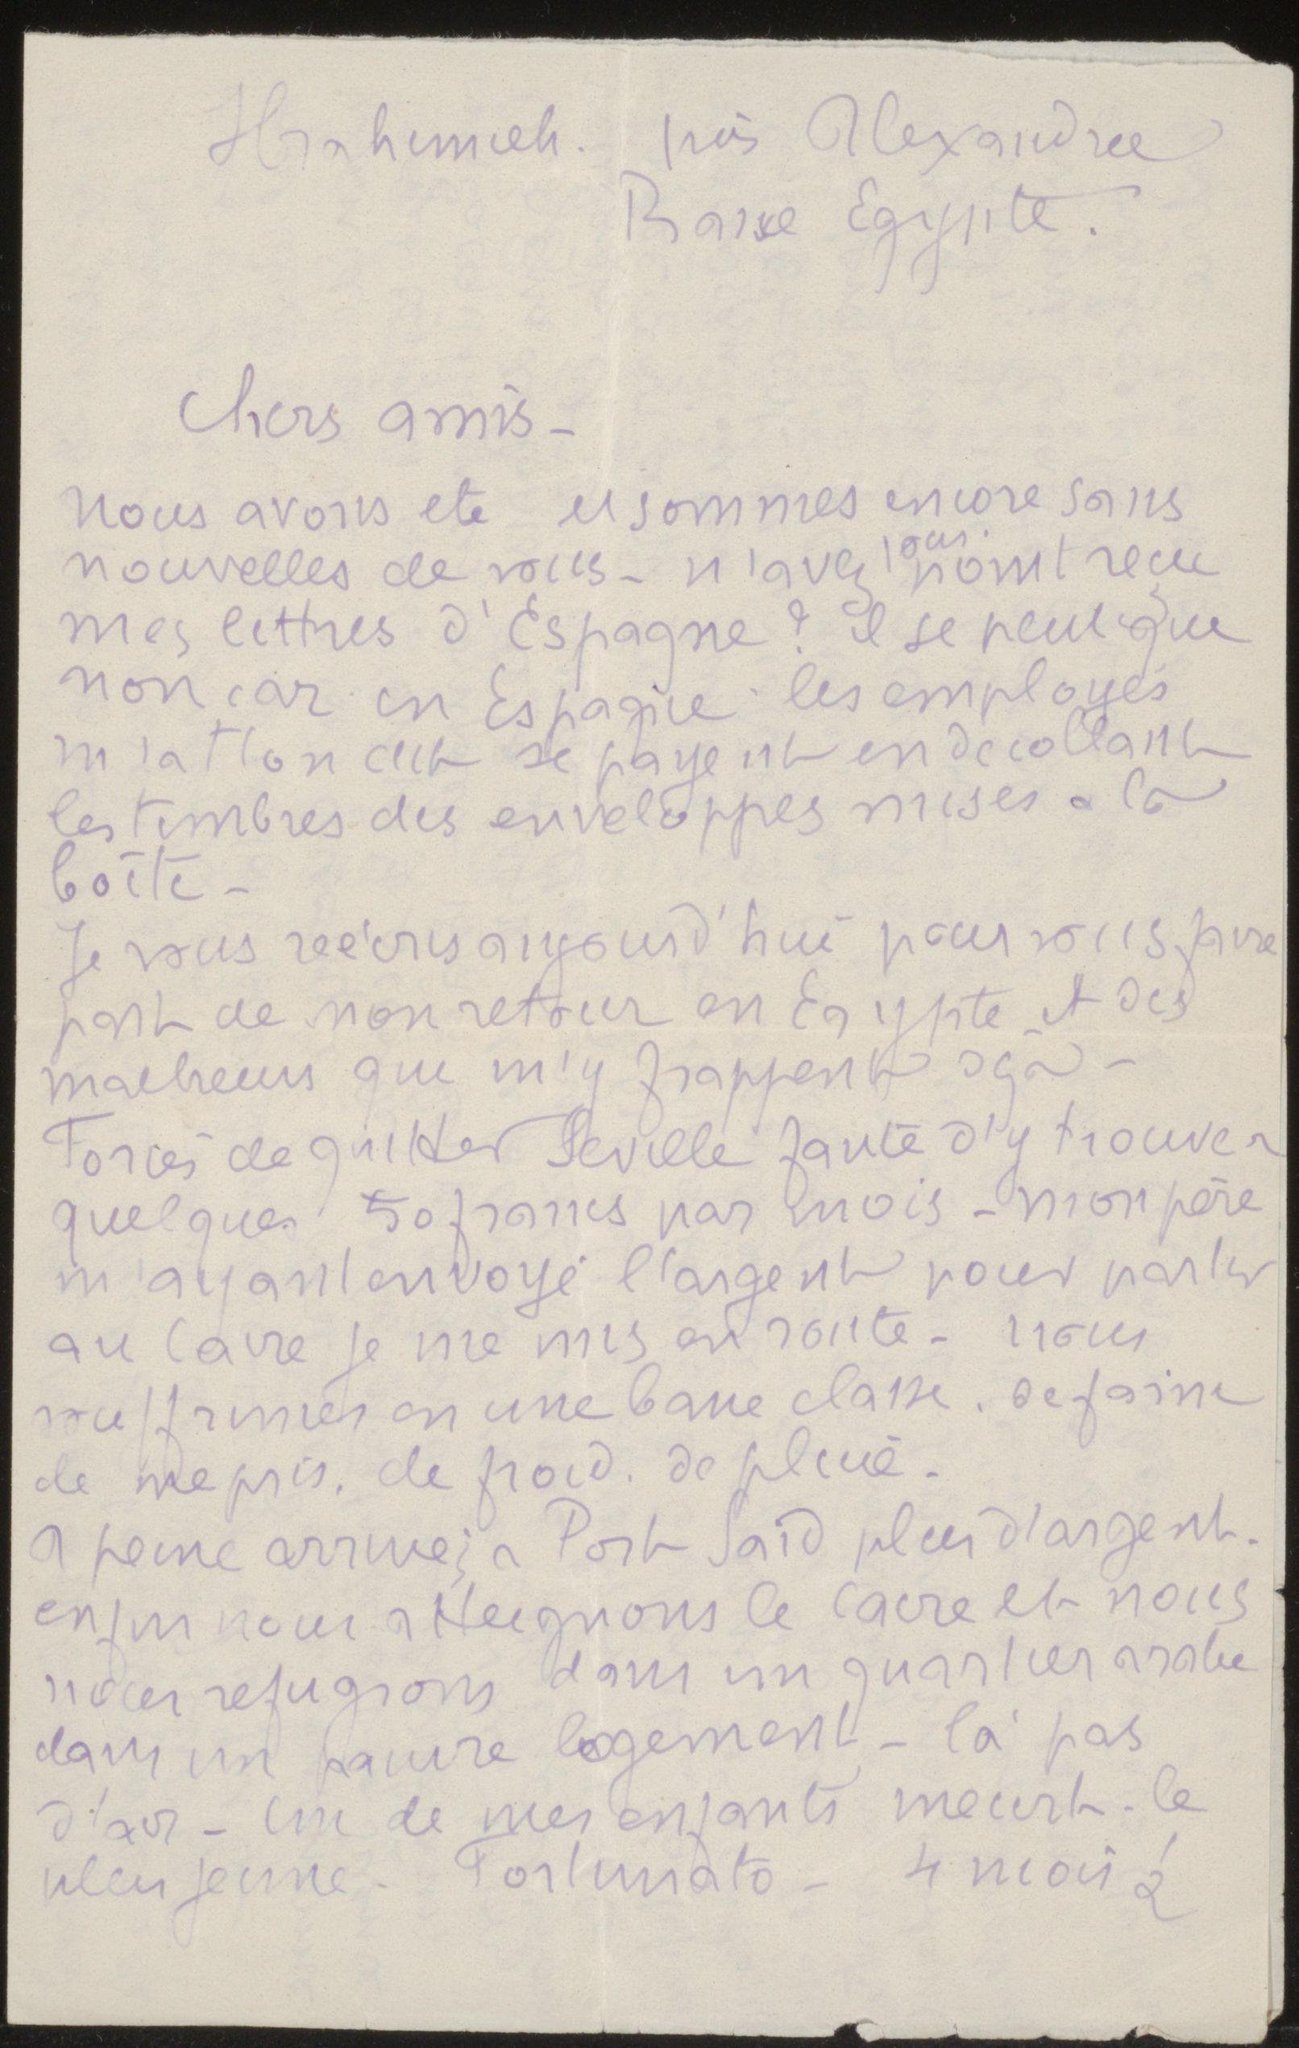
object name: letter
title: Brief aan Andries Bonger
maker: émile bernard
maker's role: print maker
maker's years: 1868-1941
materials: ink, paper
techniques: pen, writing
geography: al ibrāhīmīyah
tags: draughtsman, paul gauguin, lyon, pierre cécile puvis de chavannes, el greco, amsterdam, andries bonger, publisher, henri louis ambroise vollard, diseases, money, sevilla, spain